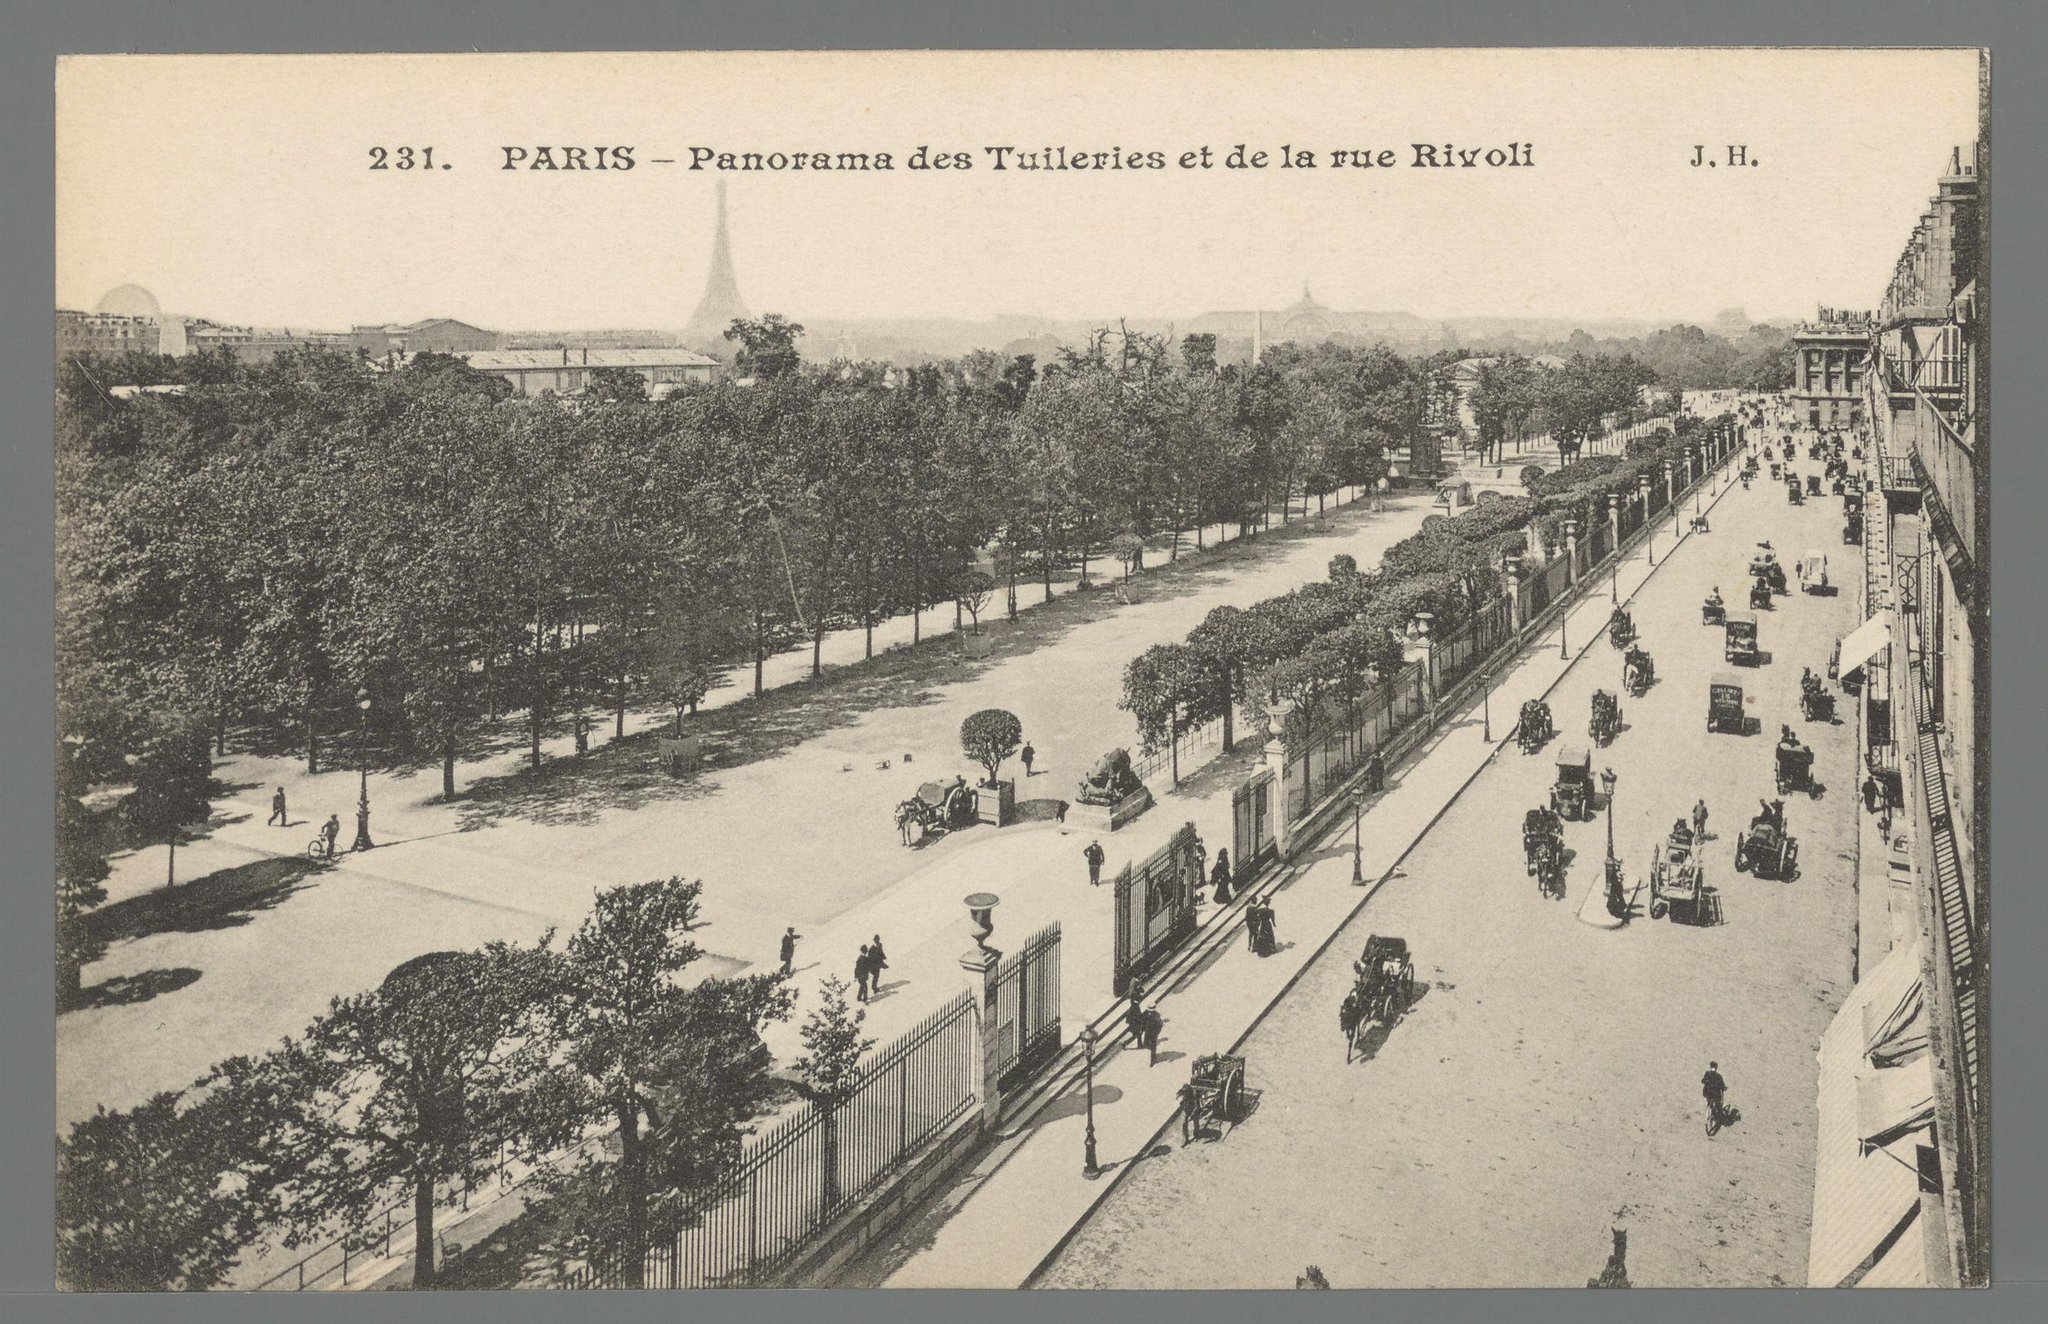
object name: photomechanical print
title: Paris. Panorama des Tuileries et de la Rue Rivoli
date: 1904-1906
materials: cardboard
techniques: photograph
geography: paris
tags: public gardens, park (+ city(-scape) with figures, staffage), avenue, boulevard, promenade, esplanade